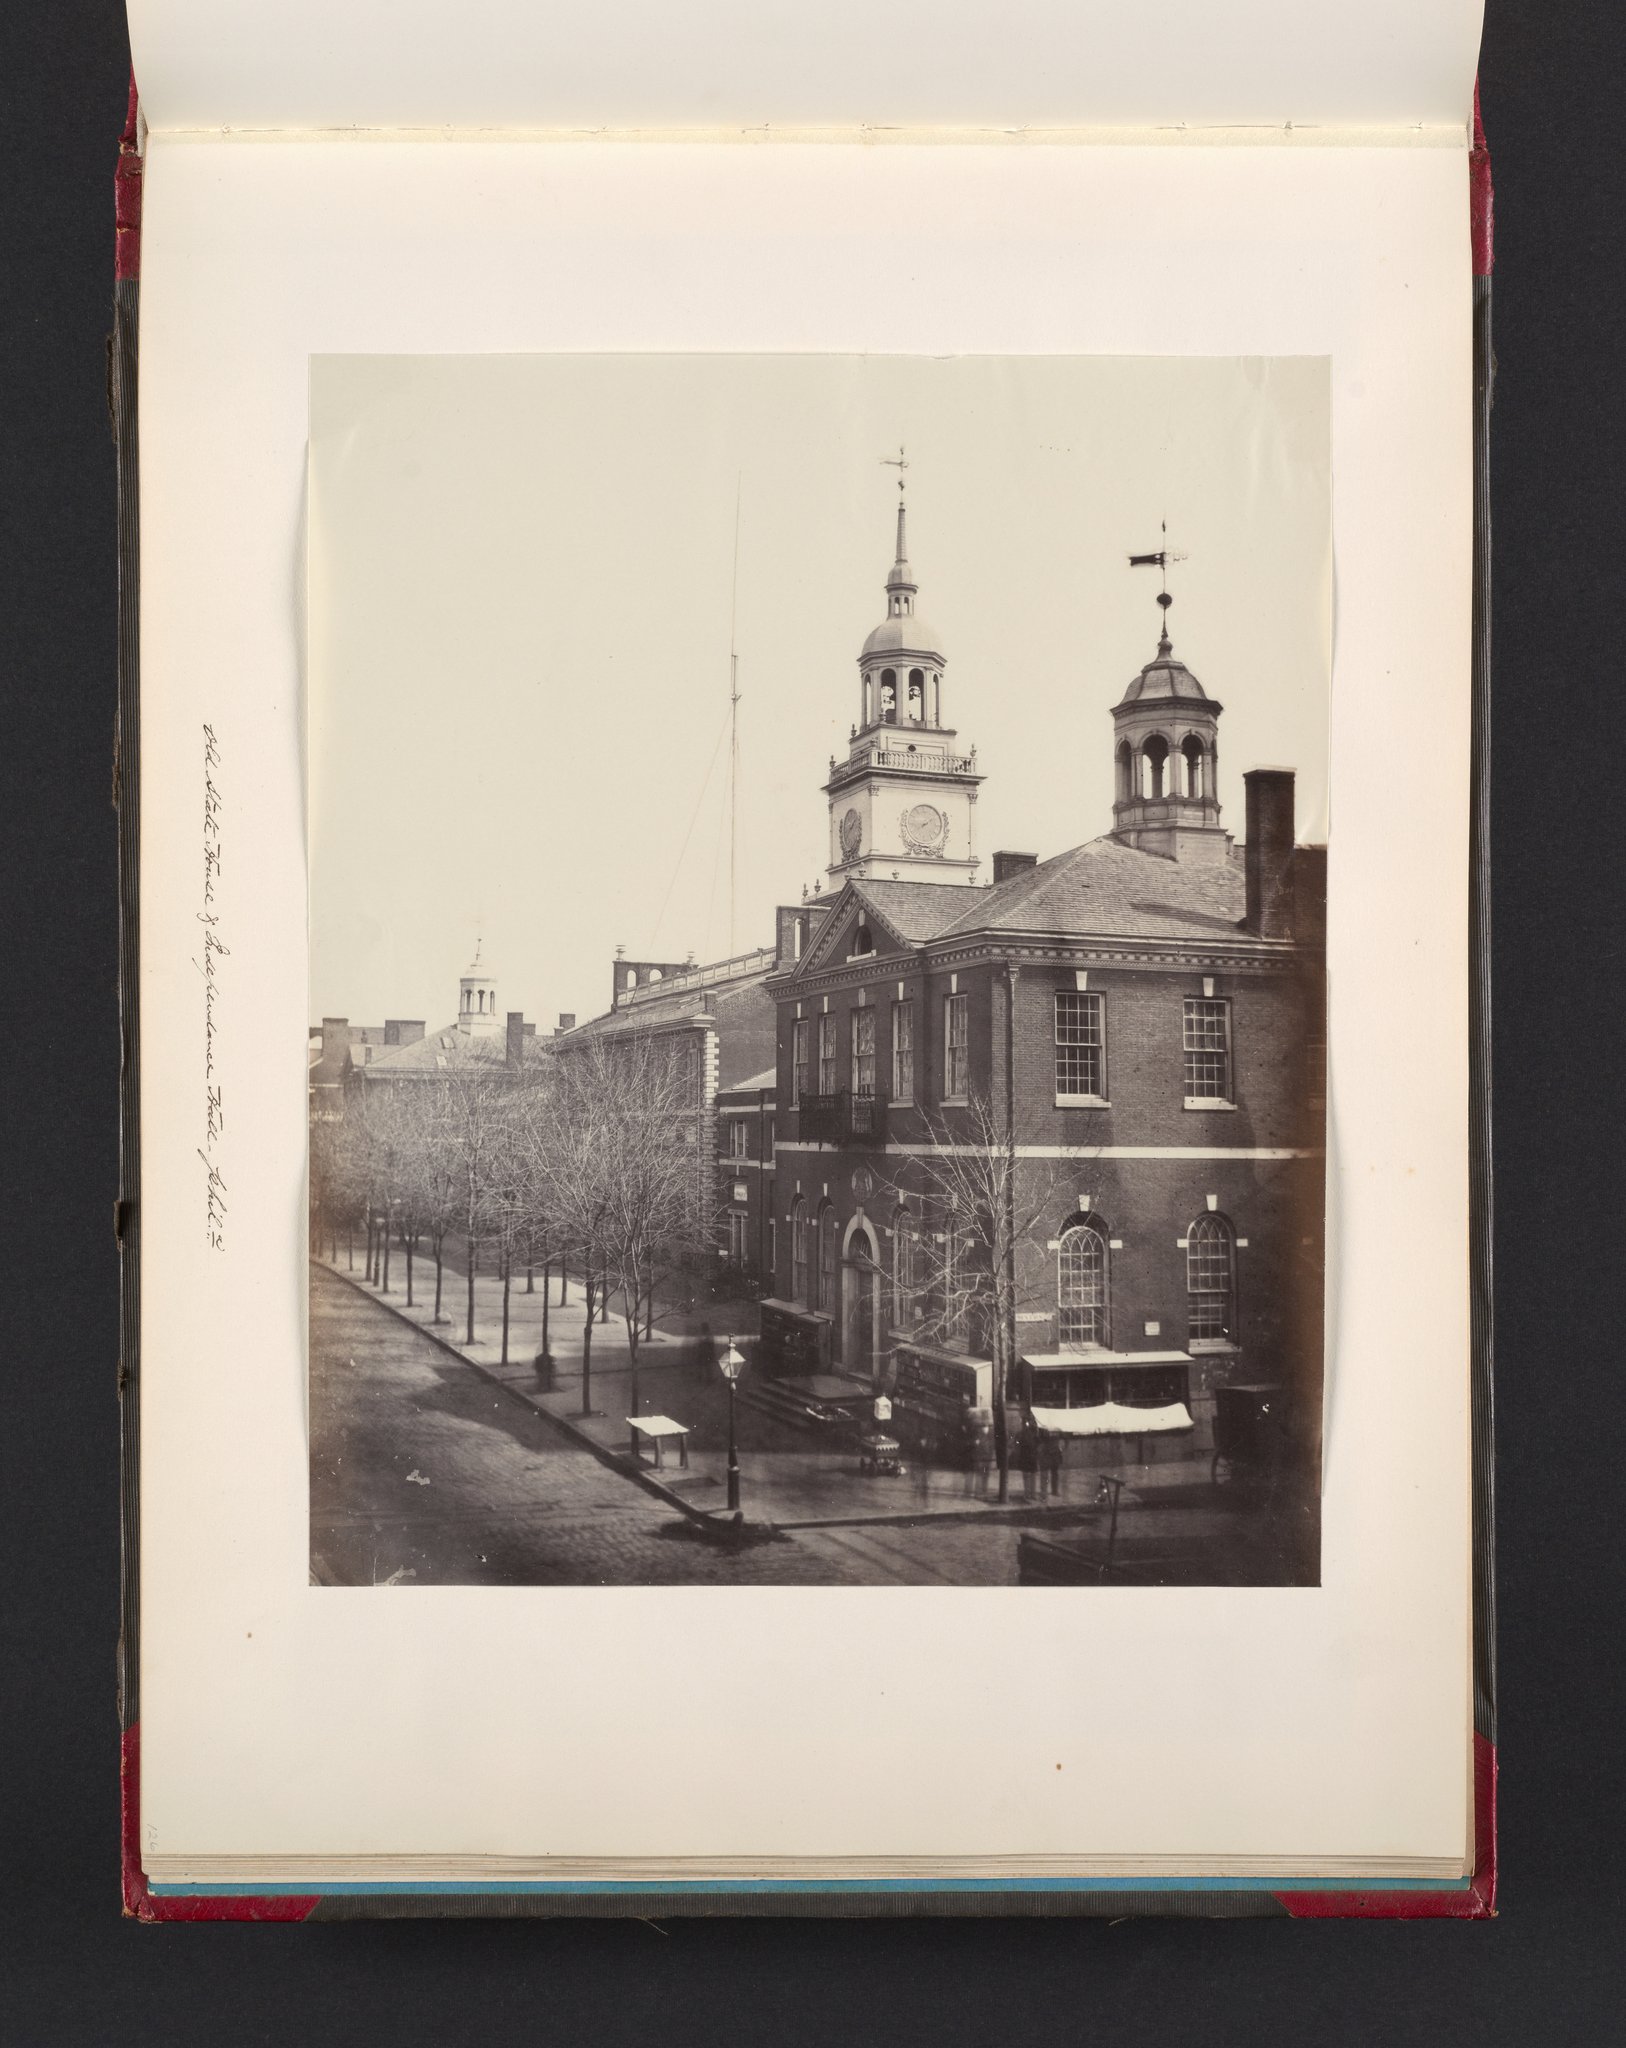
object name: photograph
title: Old State House & Independance Hall, Philadelphia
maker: john thomson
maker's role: artist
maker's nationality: british, scottish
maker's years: 1837-1921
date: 1865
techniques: albumen silver print, glass negative